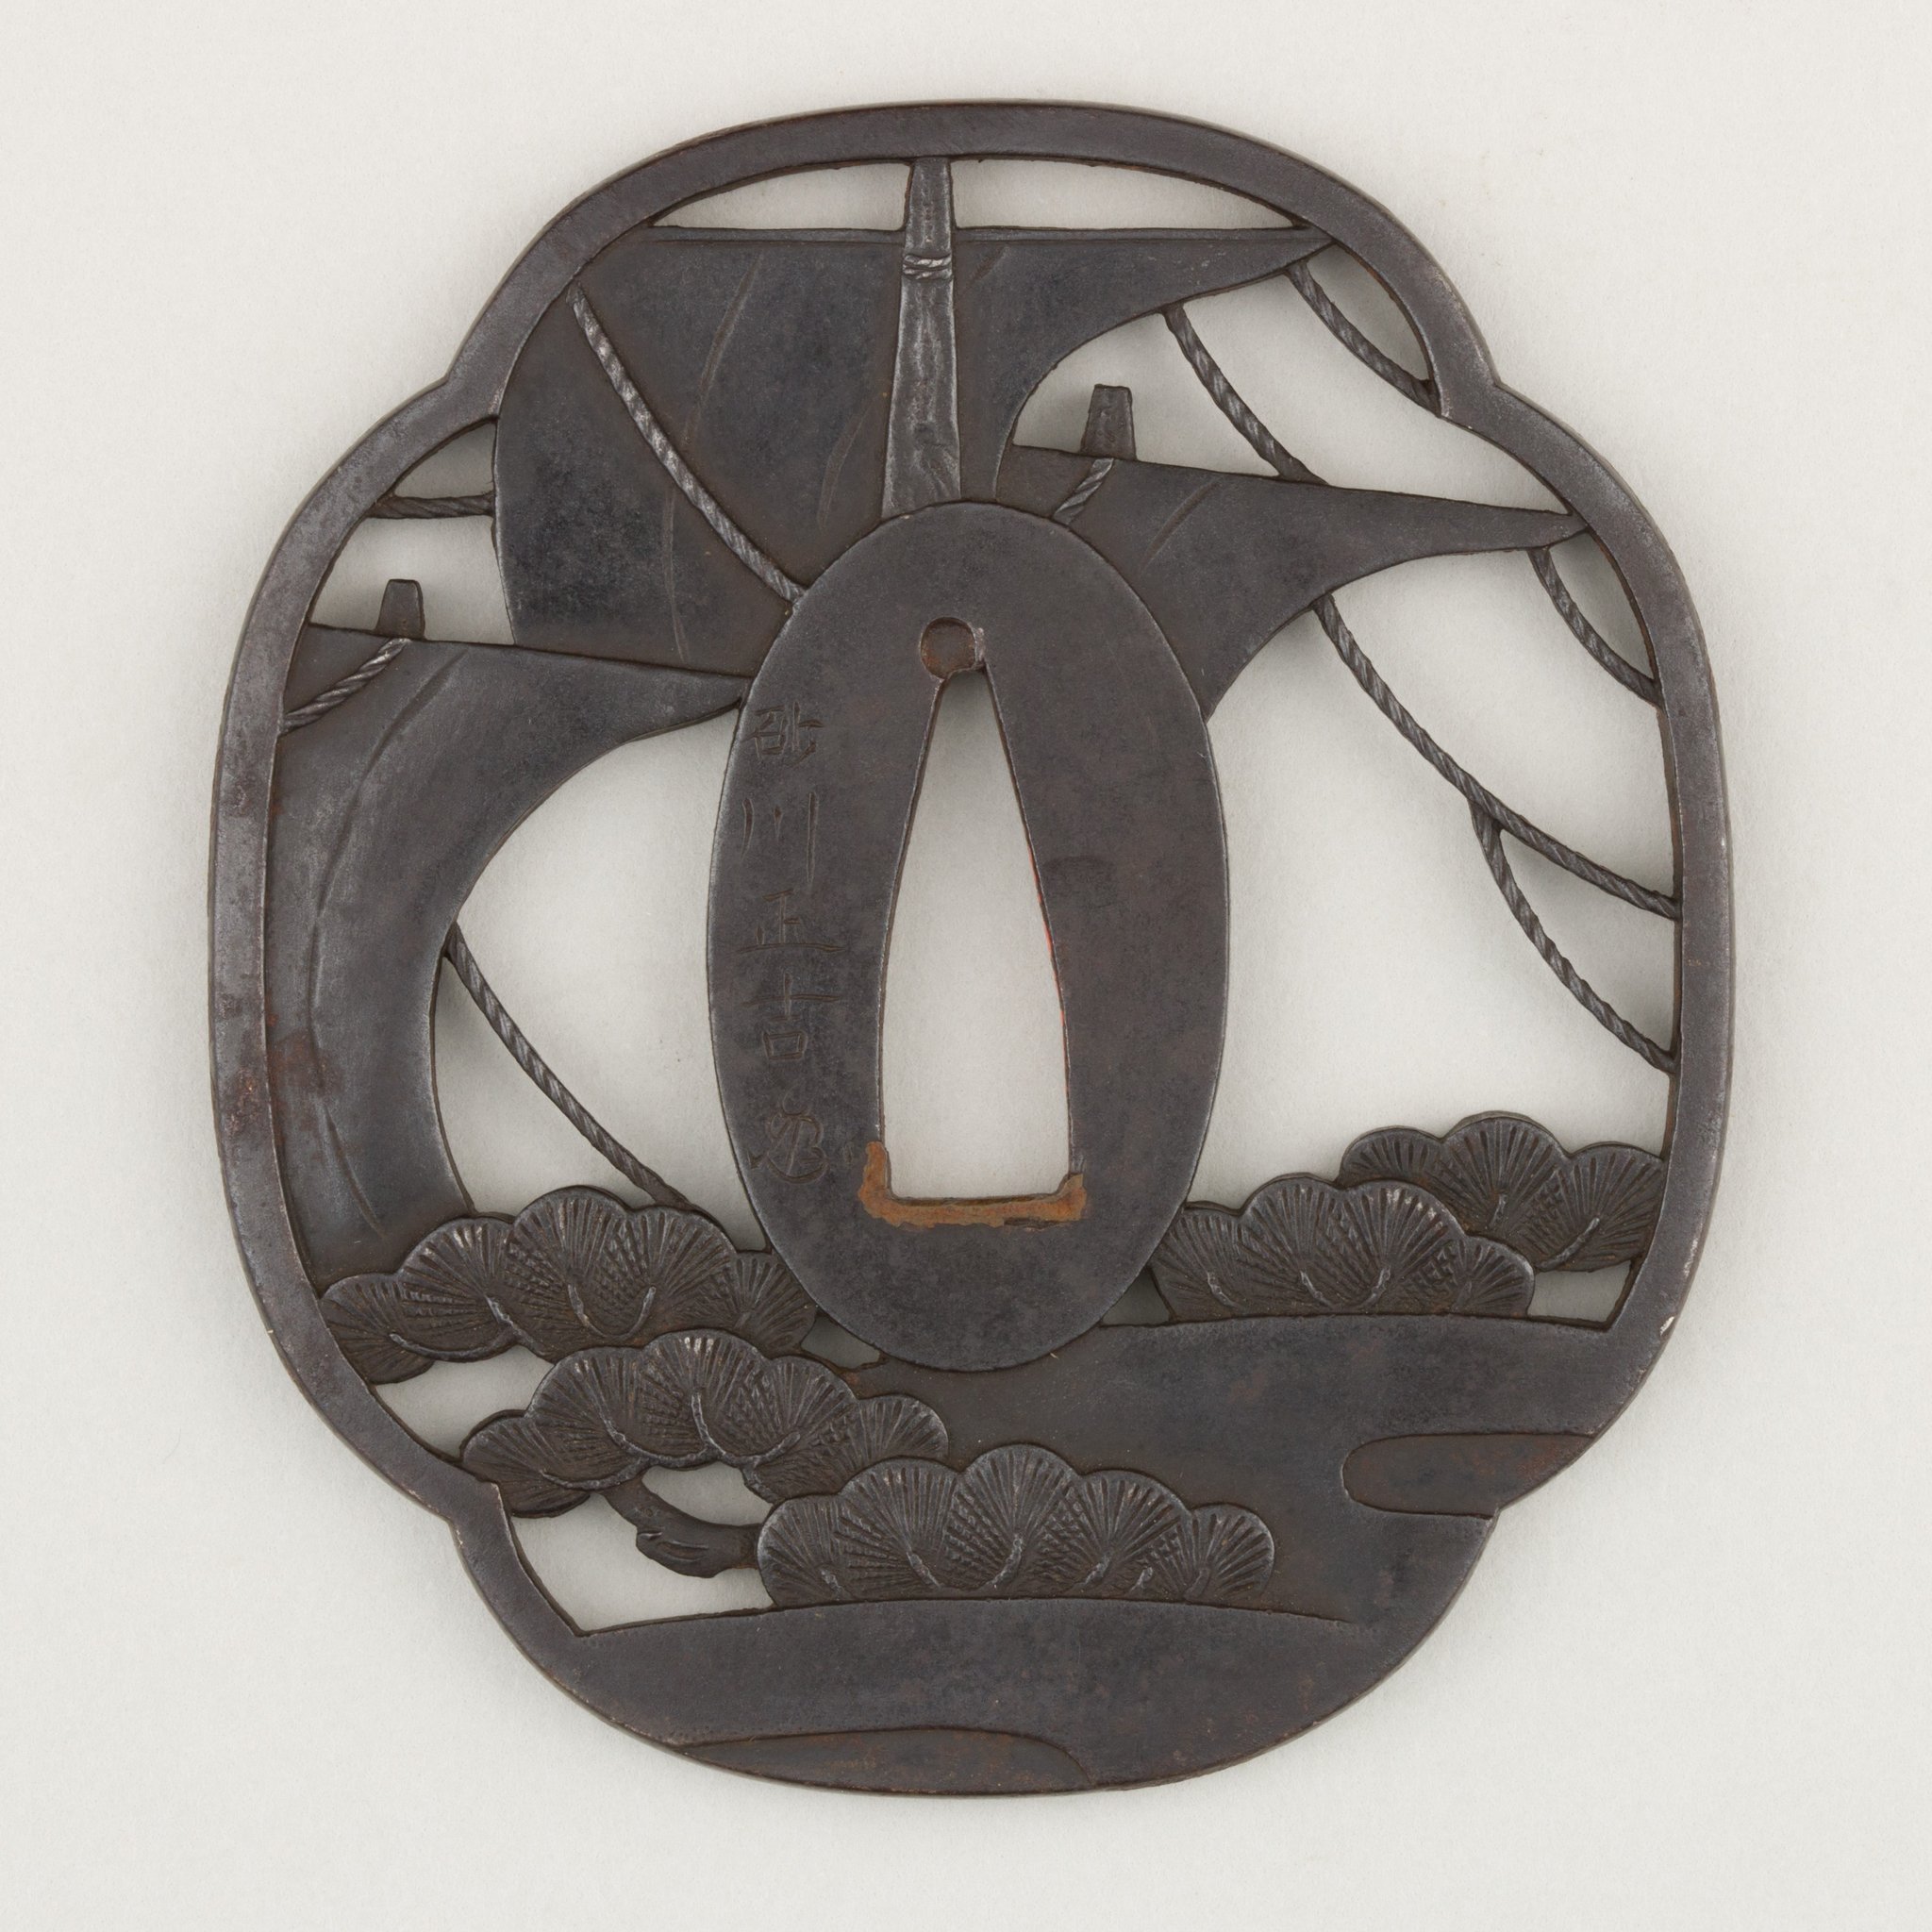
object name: sword guard tsuba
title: Sword Guard (Tsuba)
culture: japanese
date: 1701-1900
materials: copper, iron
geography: japan